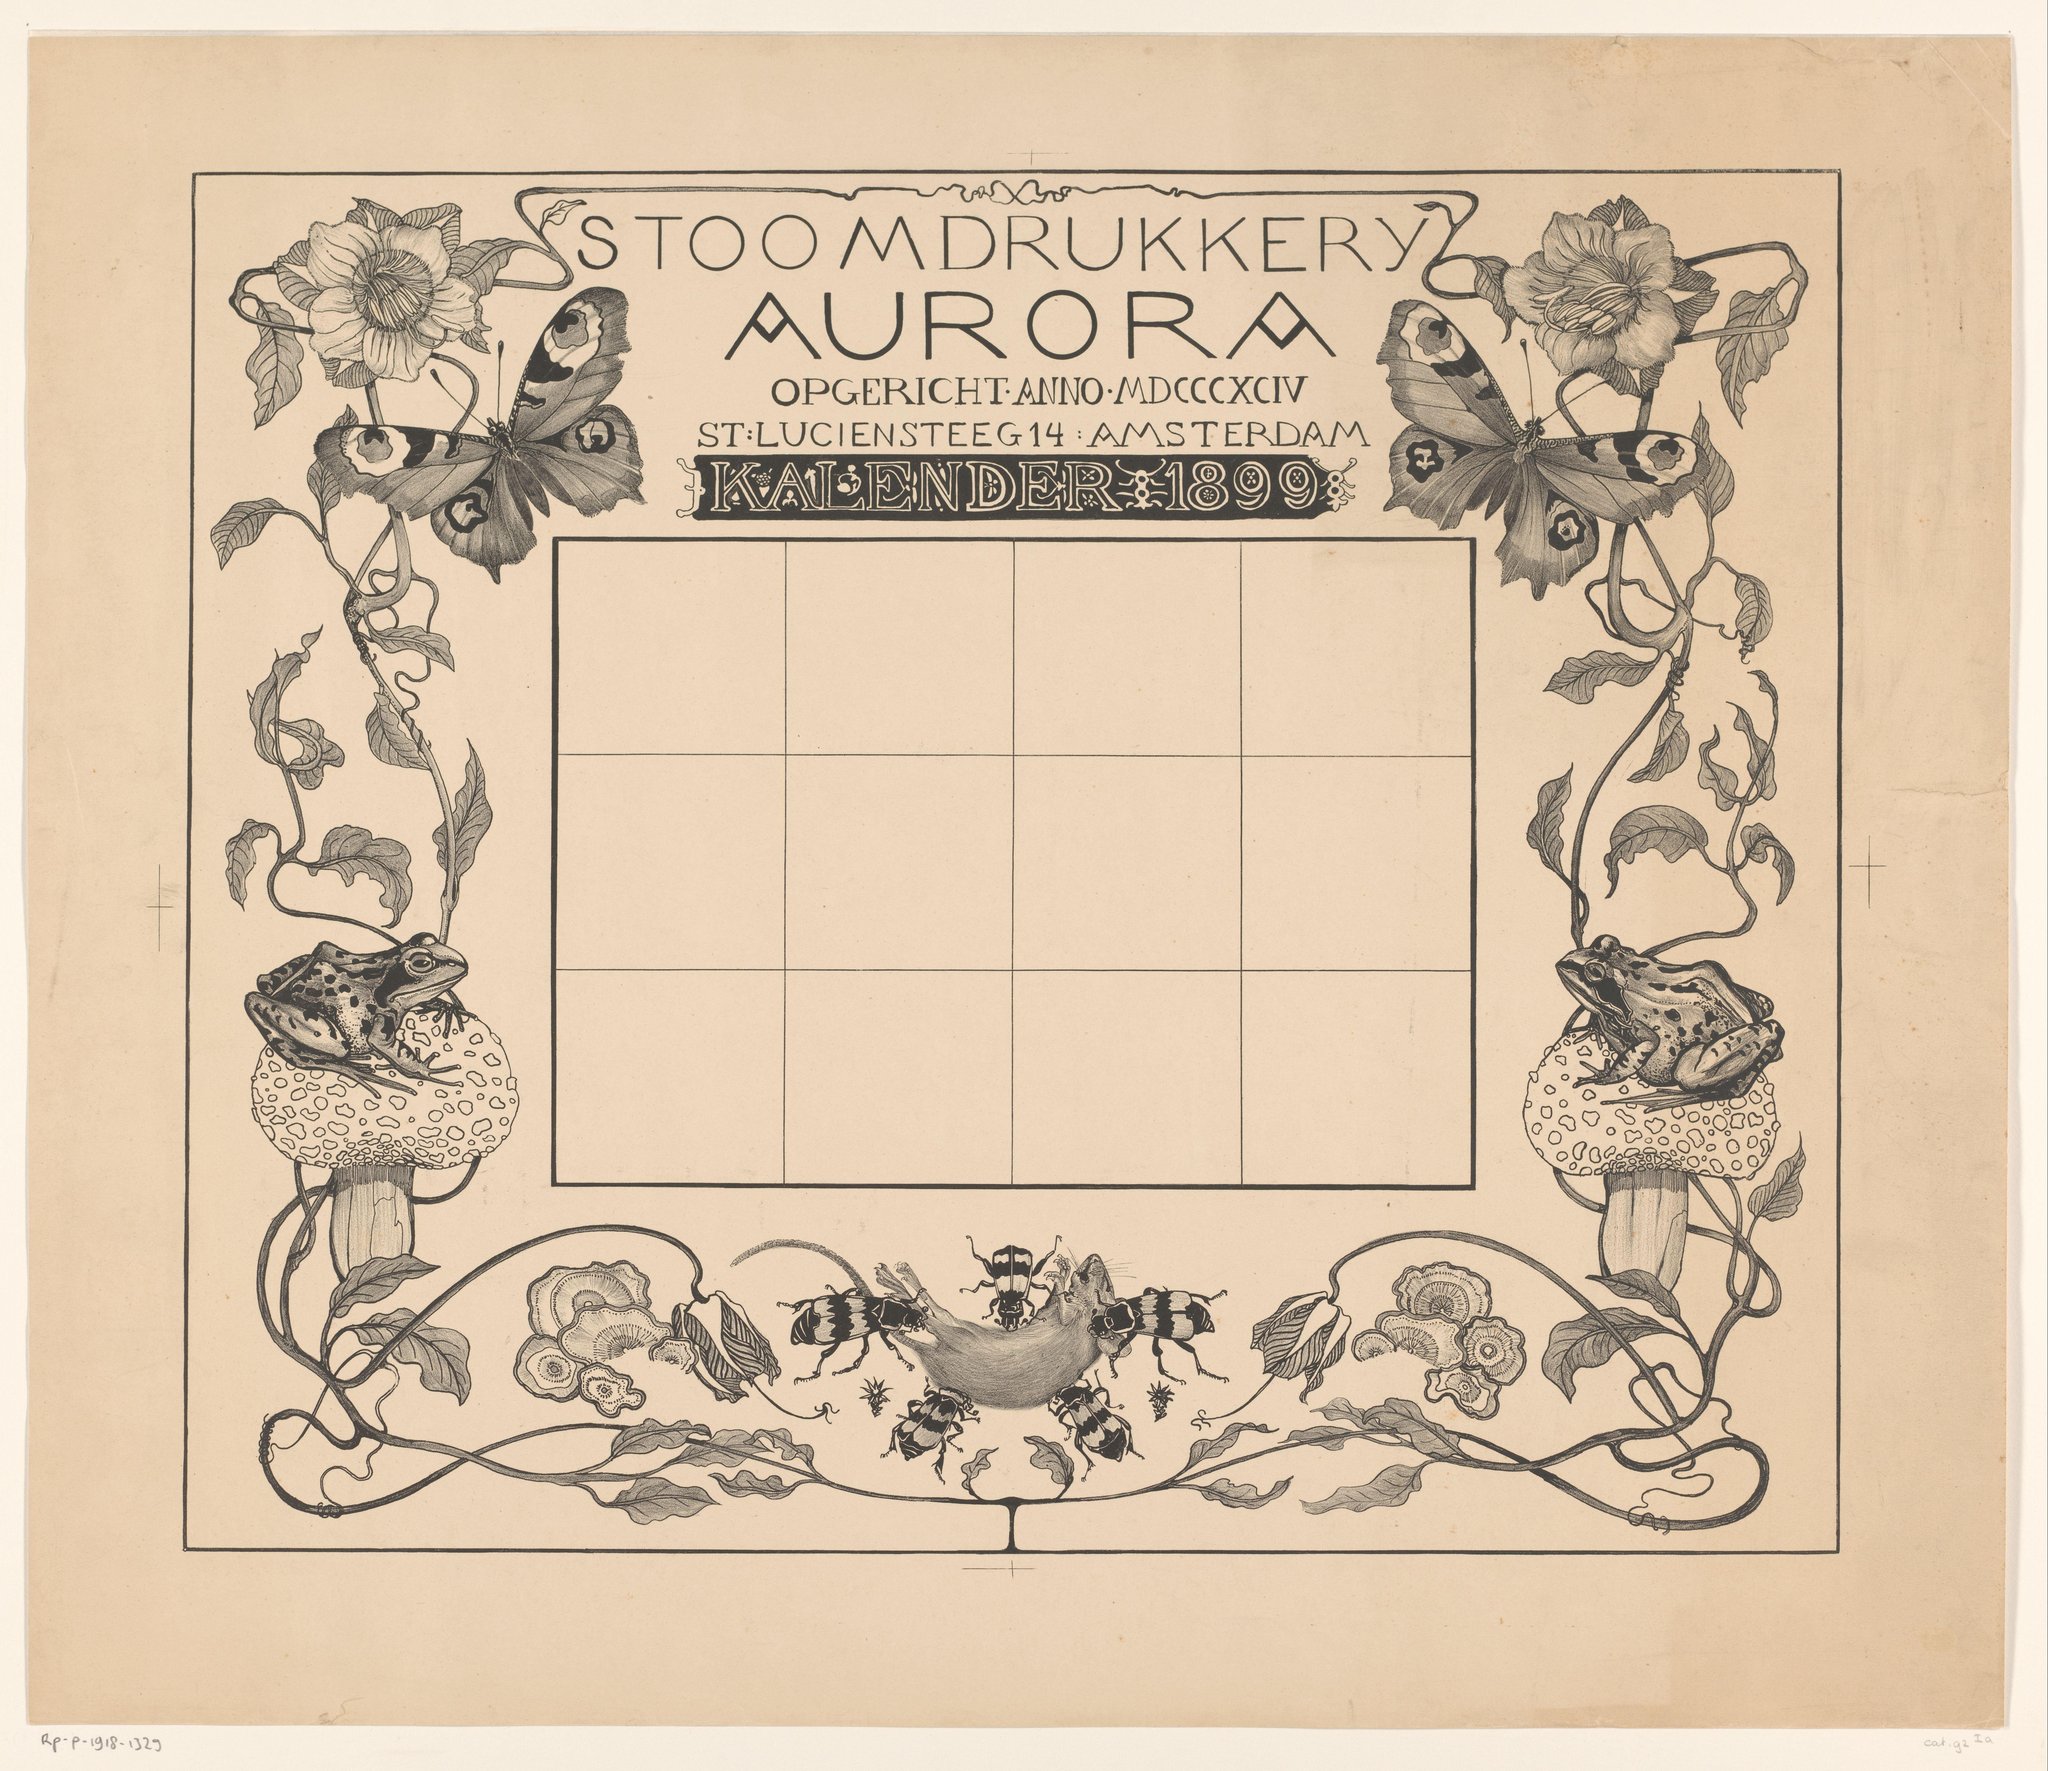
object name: calendar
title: Kalender van het jaar 1899, met bloemen, insecten en kikkers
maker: theo van hoytema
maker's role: draughtsman, painter, print maker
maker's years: 1863-1917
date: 1898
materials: paper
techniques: lithograph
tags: flowers, tailless amphibians: frog, calendar, almanac, insects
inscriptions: collector's mark: Lugt 2233